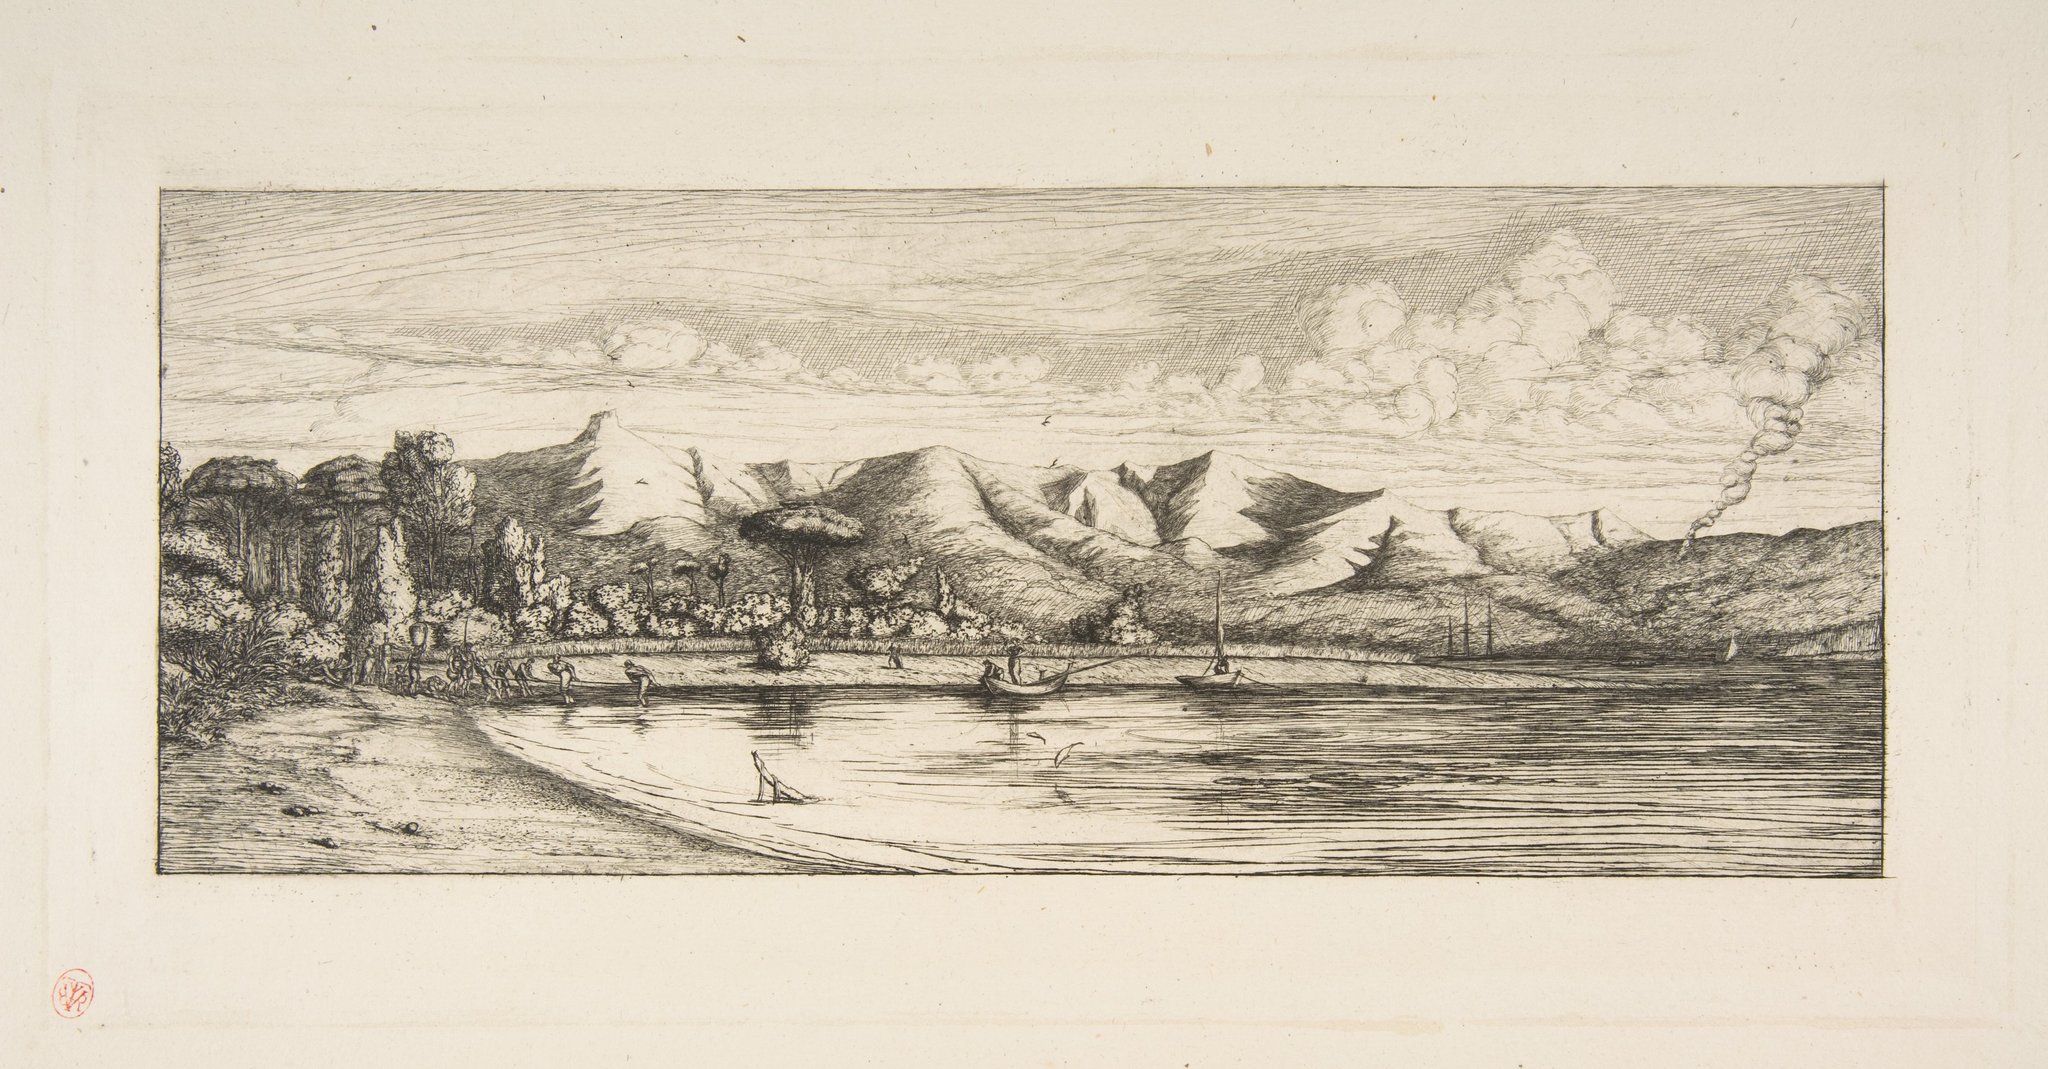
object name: print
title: Presqu'île de Banks, Pointe des Charbonniers, Akaroa (Seine fishing off Colliers' Point, Akaroa, Banks Peninsula, 1845), from "The Voyage to New Zealand (1842–46)"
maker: charles meryon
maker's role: artist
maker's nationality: french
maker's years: 1821-1868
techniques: drypoint, etching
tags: fishing,landscapes,boats